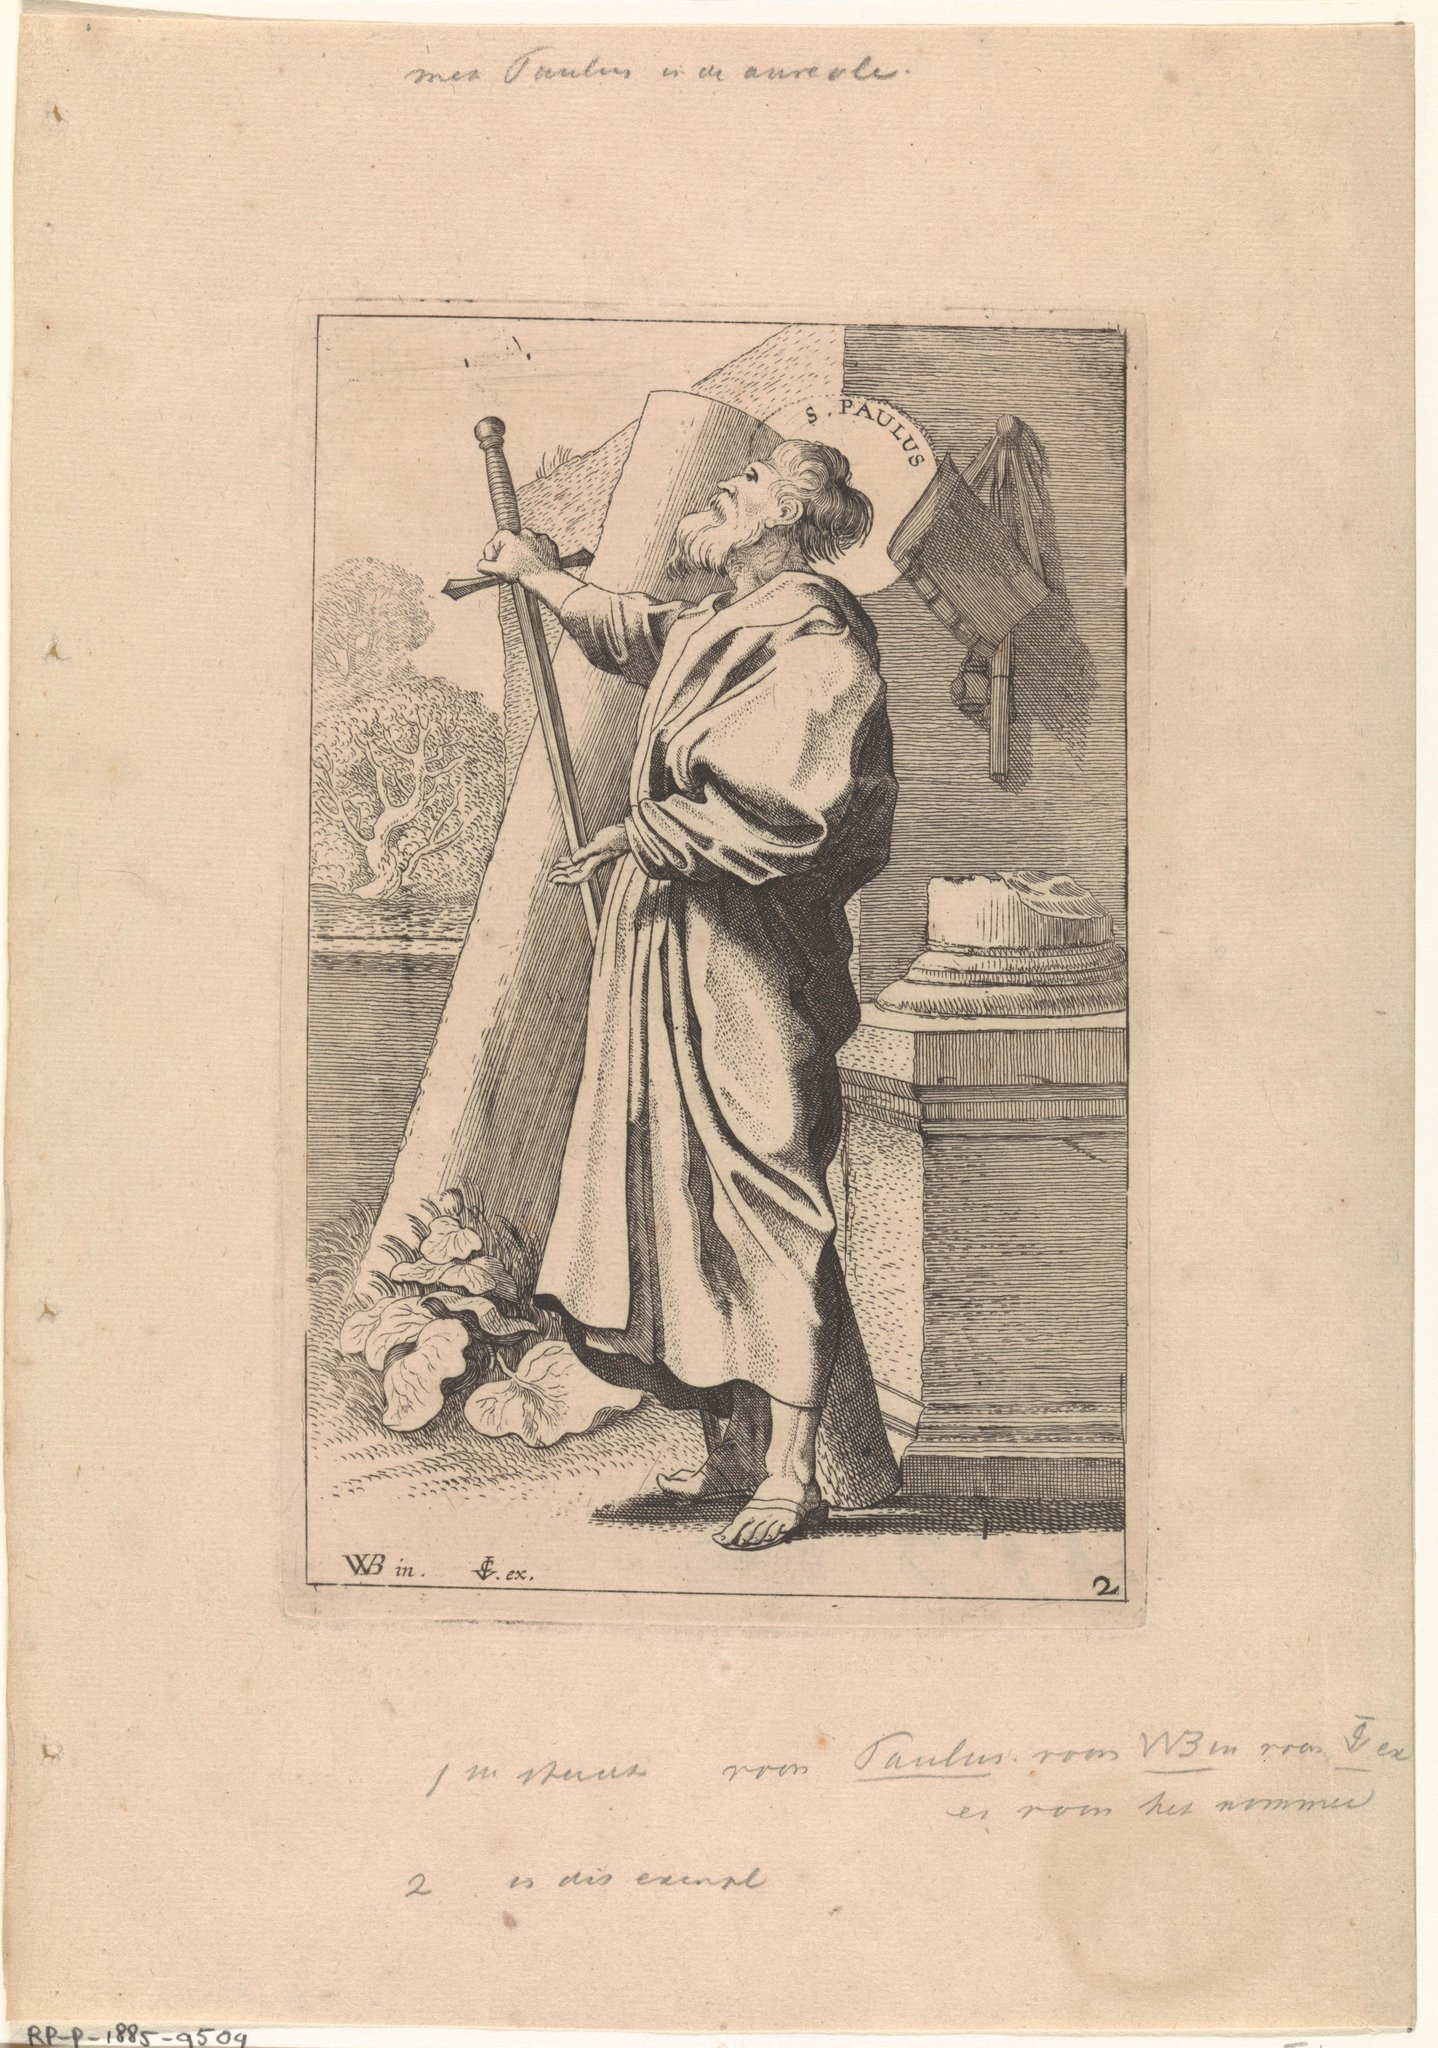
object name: print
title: H. Paulus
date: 1603-1652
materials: paper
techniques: engraving, etching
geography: amsterdam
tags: the apostle paul of tarsus; possible attributes: book, scroll, sword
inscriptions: collector's mark: Lugt 2228, signature: ‘WB in.’, address: ‘CIV ex.’, collector's mark: Lugt 240, title: ‘S.PAULUS’, number: ‘2’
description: De apostel Paulus, met zwaard, staand voor een gebroken zuil, naar links, opkijkend naar de hemel.